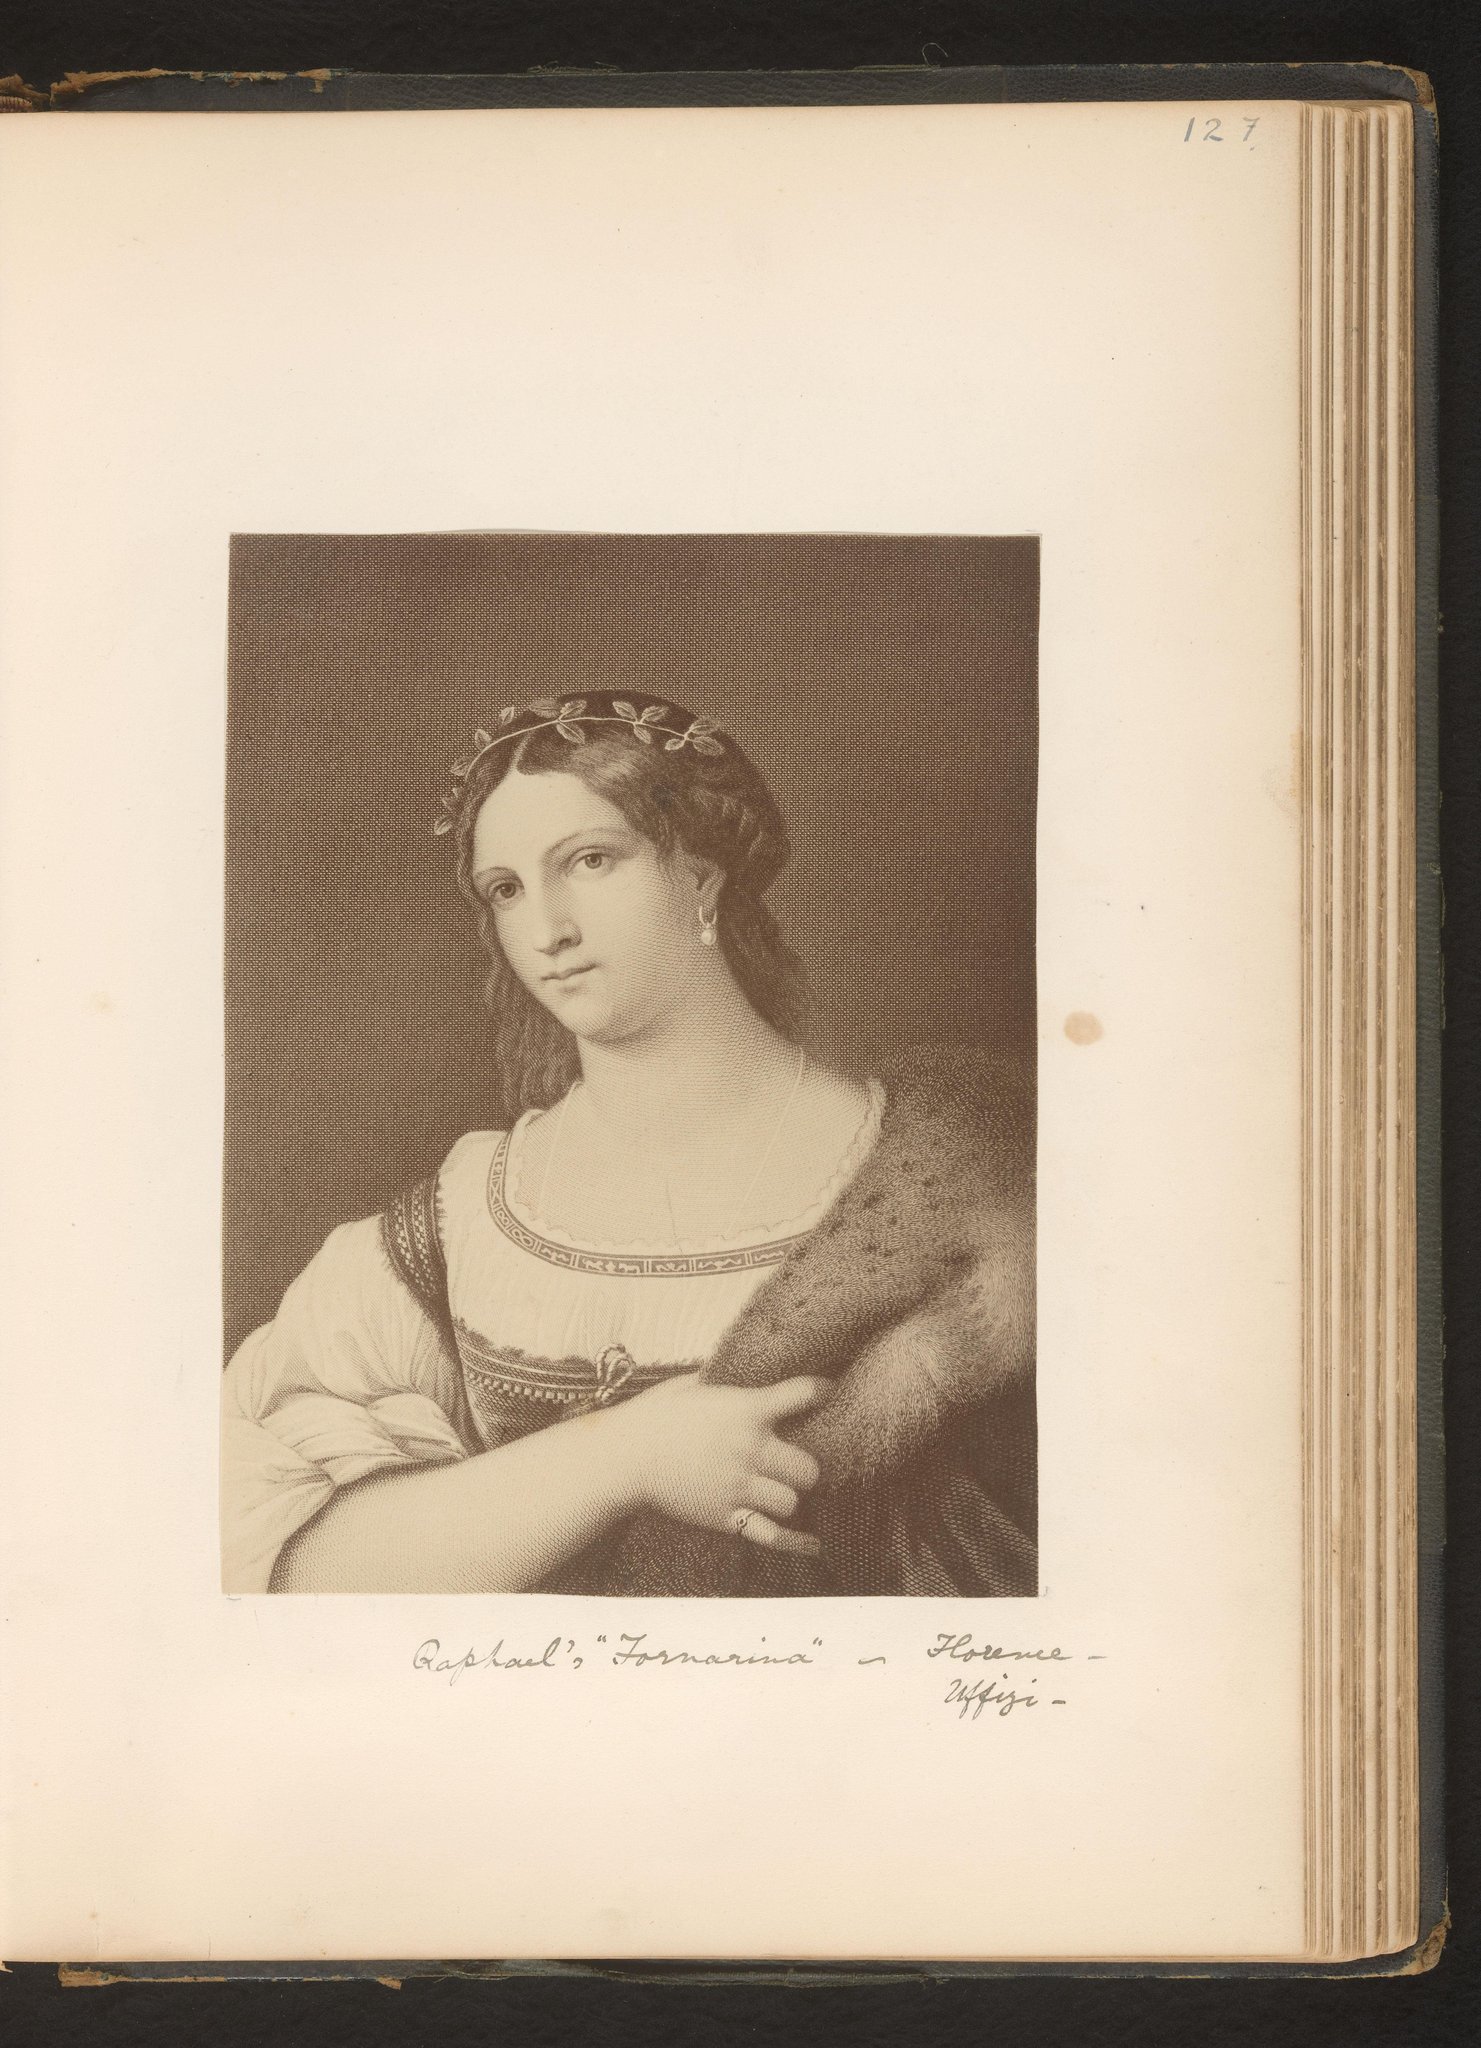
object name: album leaf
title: Fotoreproductie van een prent van een portret van een vrouw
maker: Anonymous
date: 1810-1873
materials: paper, photographic support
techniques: albumen print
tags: print, e.g.: engraving, etching, lithograph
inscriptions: annotation: ‘Raphael, "Fornarina"- Florence- Ufifizi’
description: Deze pagina maakt deel uit van een album.